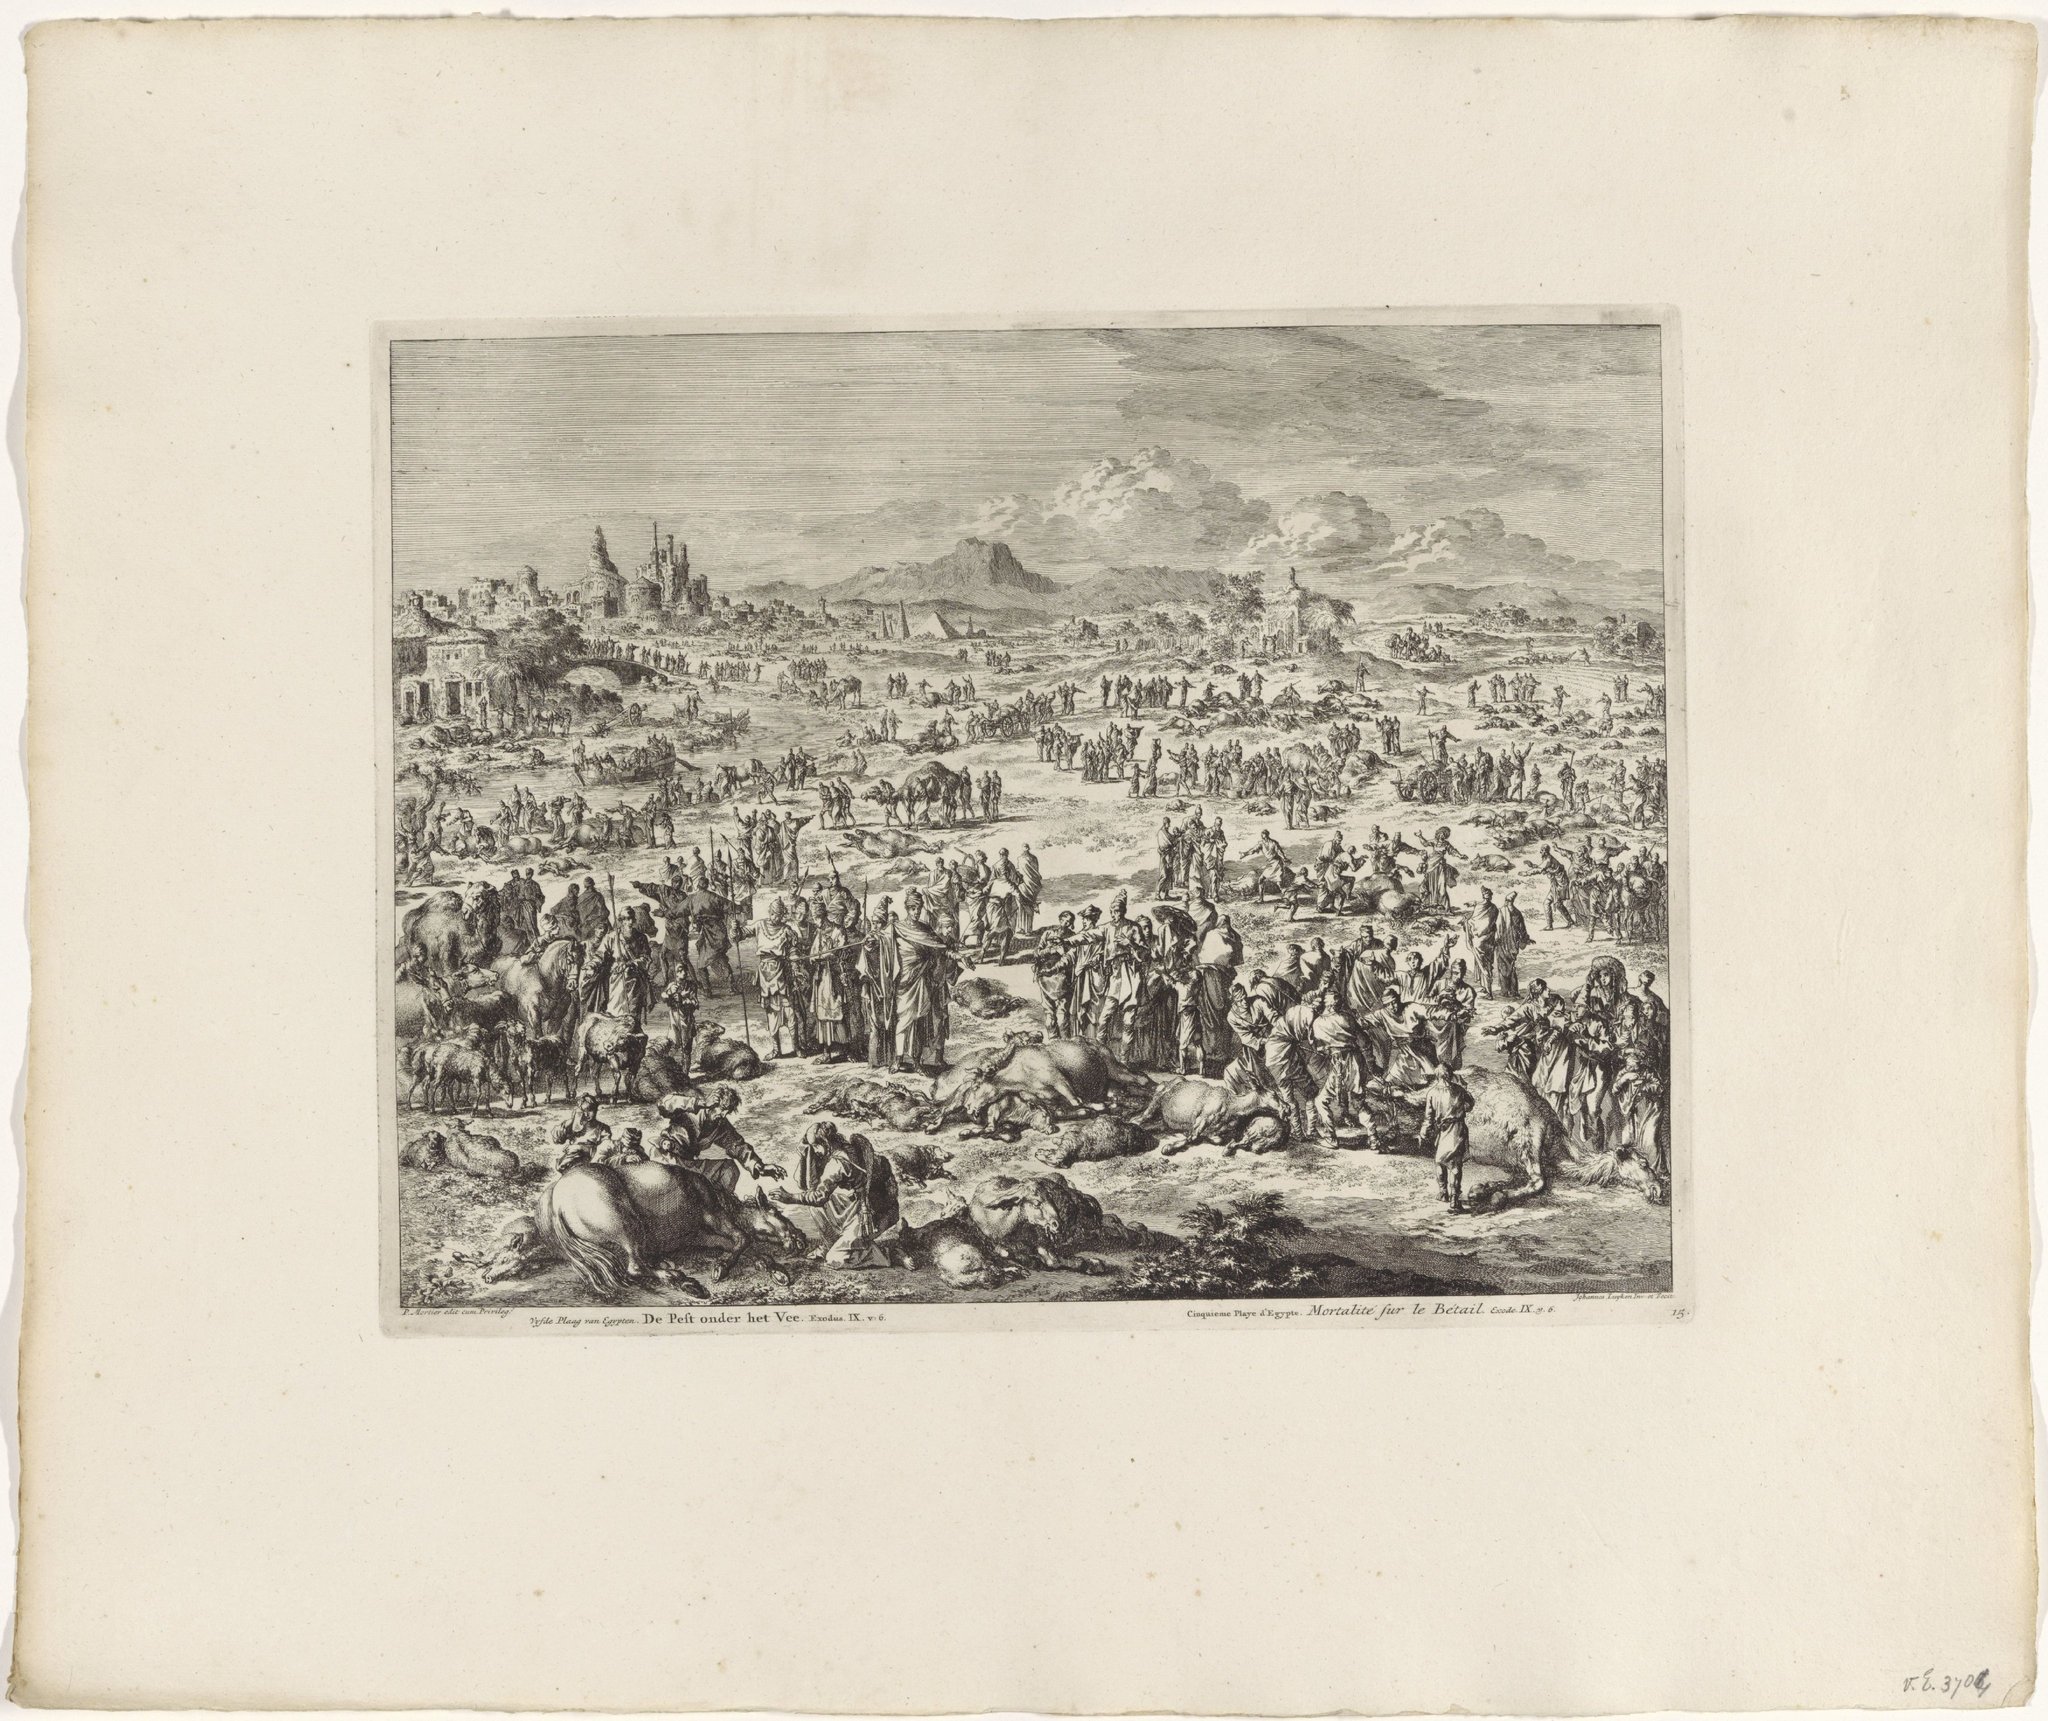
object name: print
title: Vyfde Plaag van Egypten. De Pest onder het Vee.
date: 1708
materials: paper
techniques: etching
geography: amsterdam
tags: the plague of murrain in cattle: all the animals of the egyptians die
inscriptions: collector's mark: Lugt 2228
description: Gezicht op een landschap bij een stad waar mensen treuren en gebaren van wanhoop maken bij hun door de pest gestorven of stervende vee. De prent is een verbeelding van de vijfde plaag die God over Egypte liet komen.